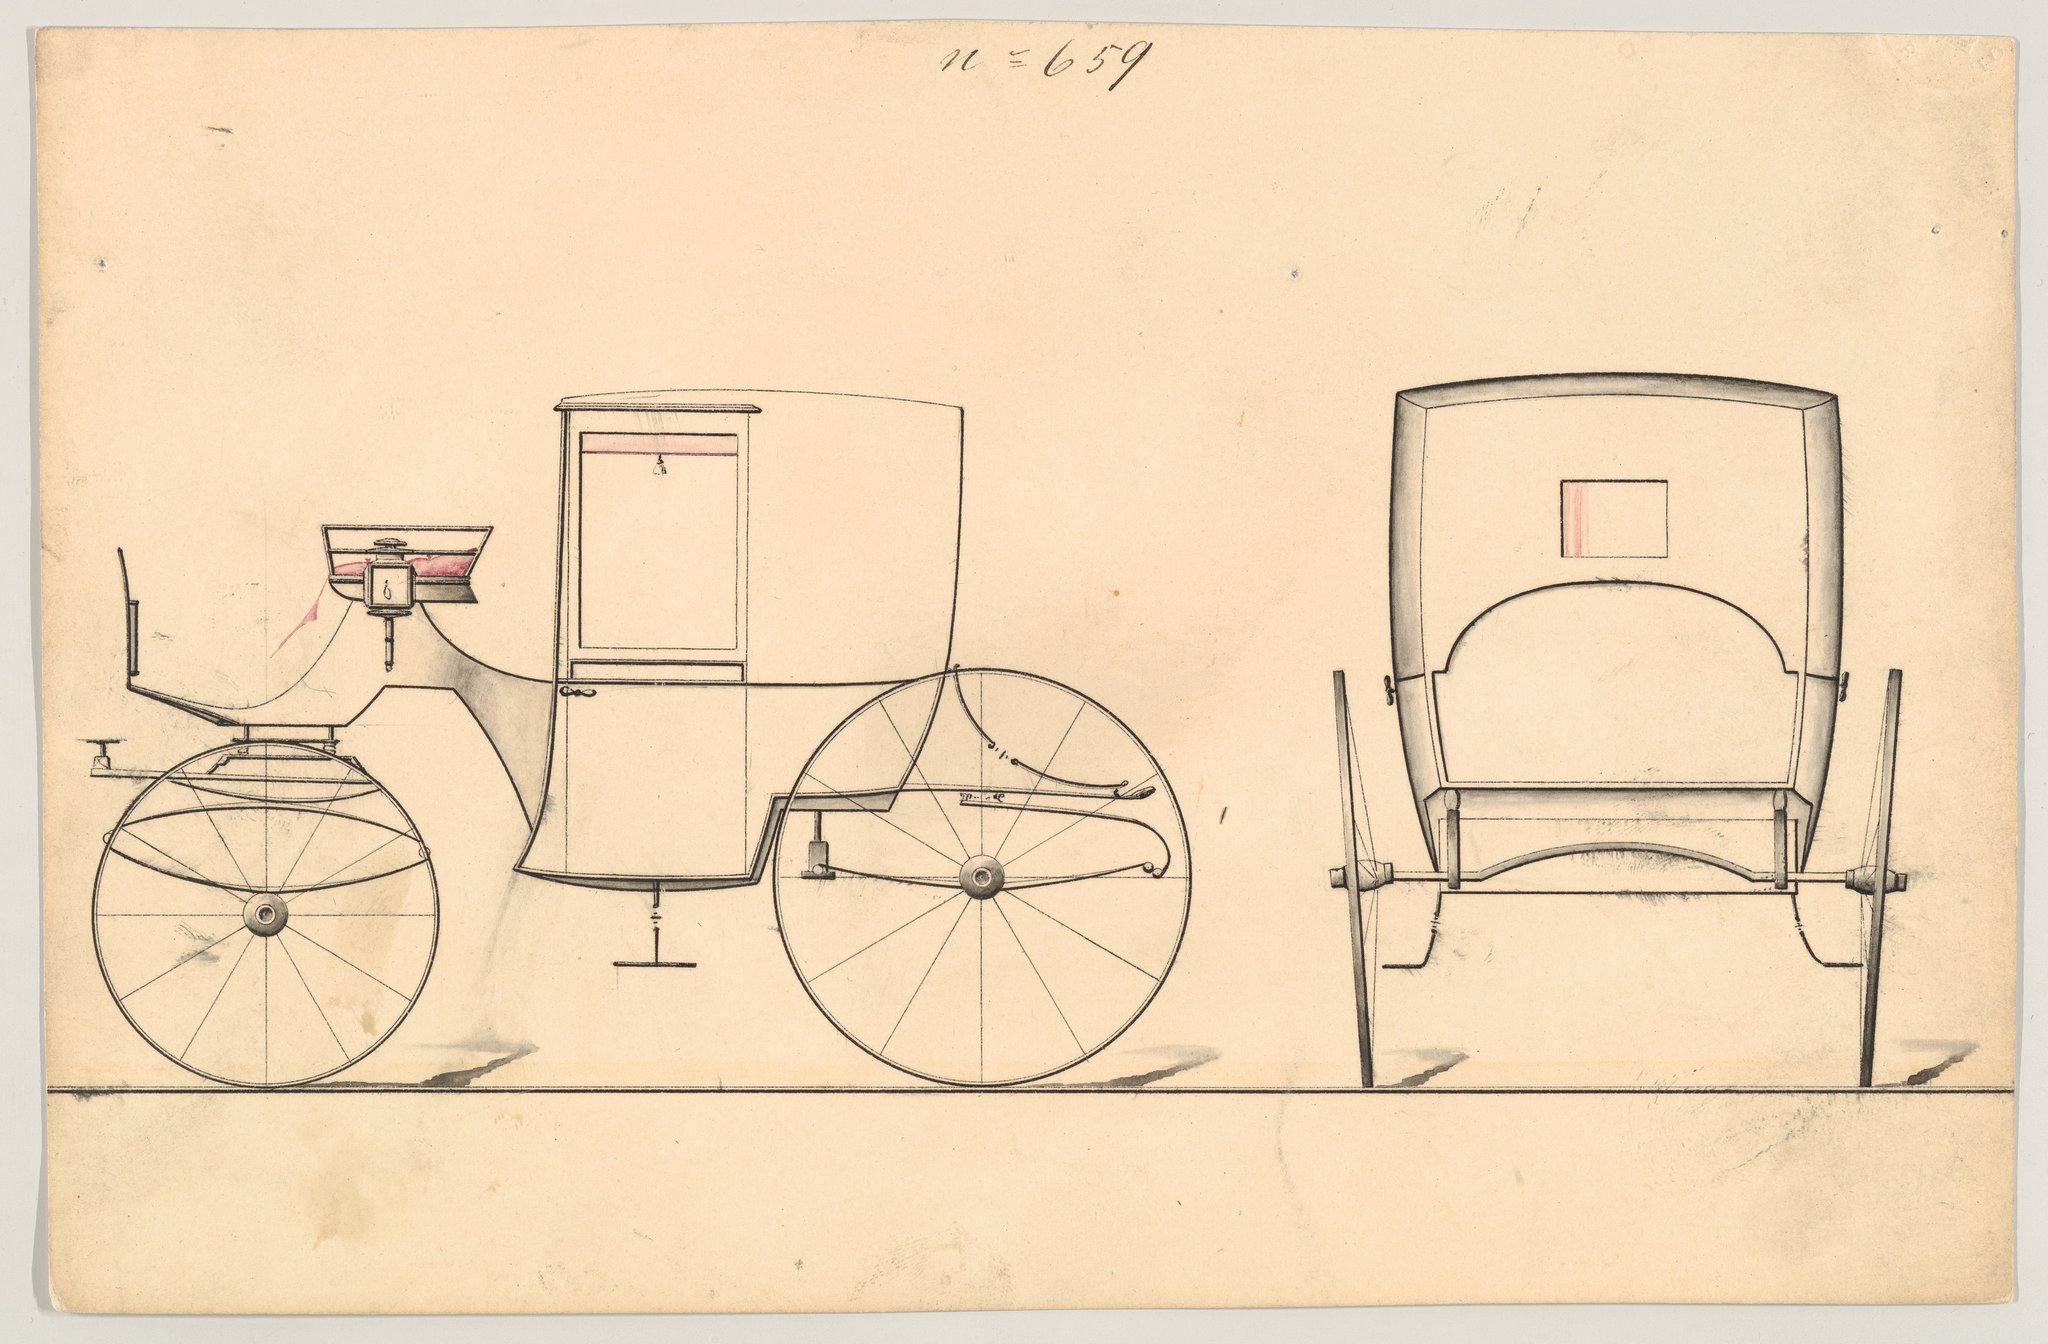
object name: drawing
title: Coupe #659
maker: brewster & co.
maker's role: manufacturer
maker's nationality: american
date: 1850-1870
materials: ink, watercolor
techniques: pen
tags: carriages